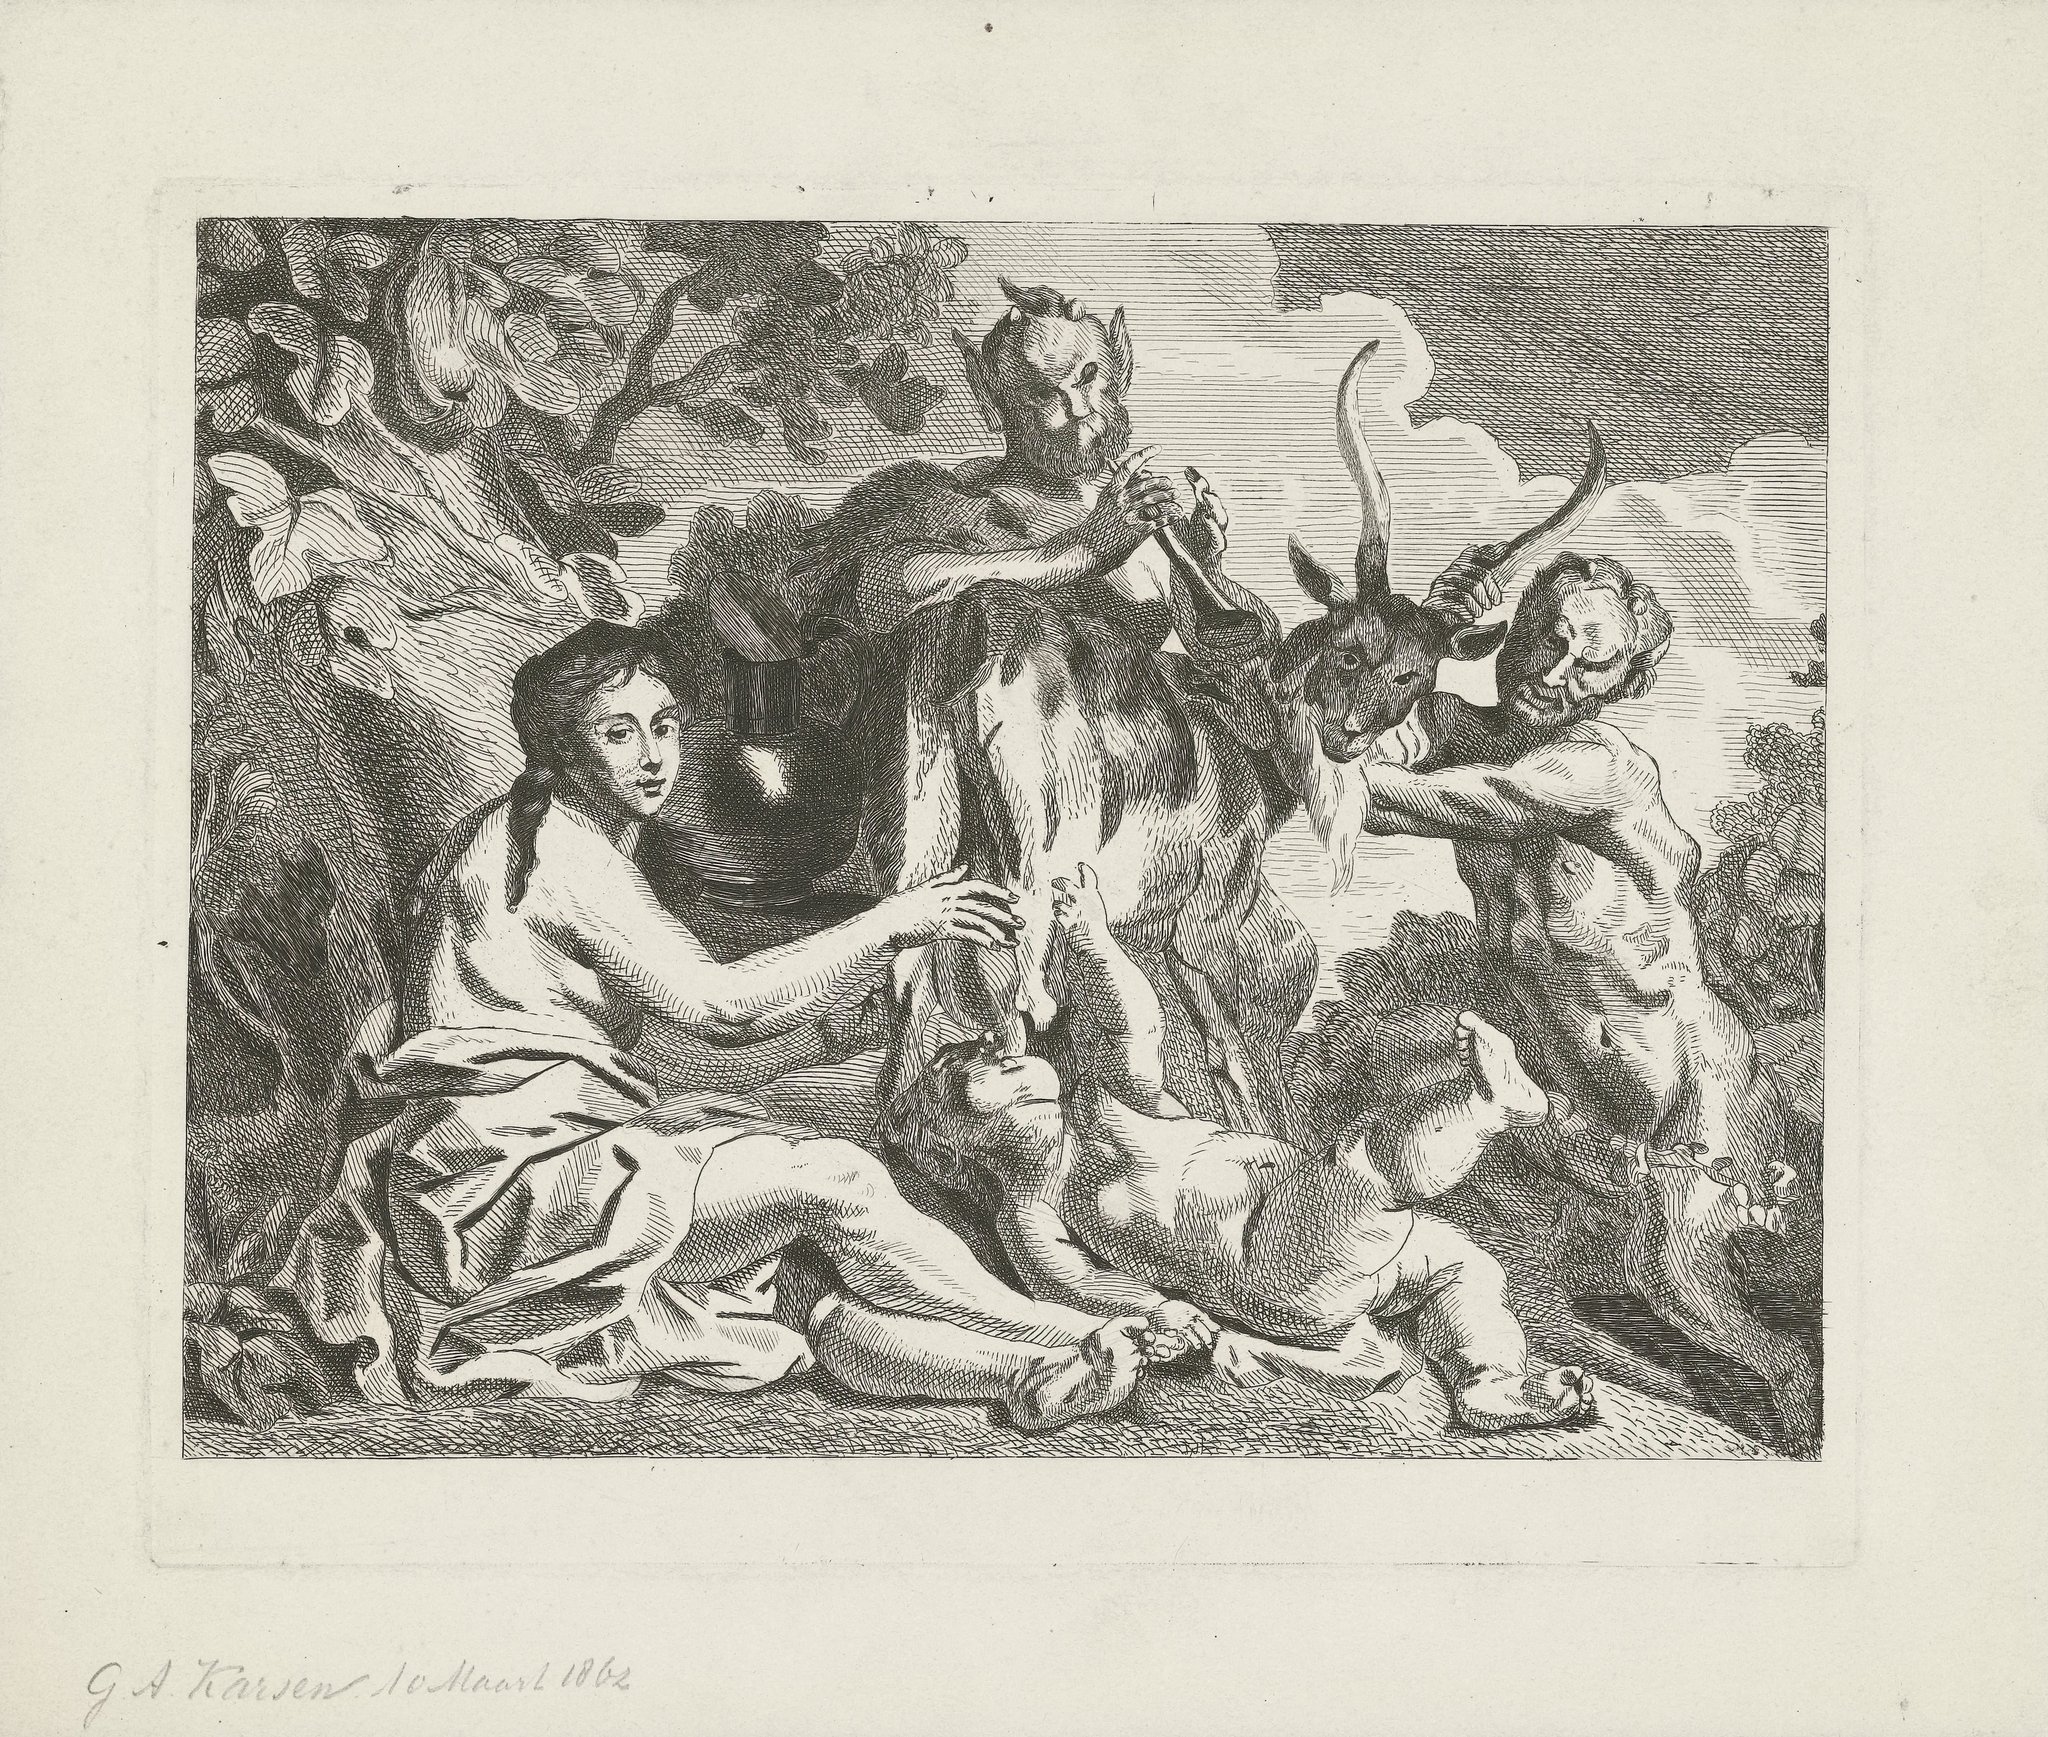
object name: print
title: Het kind Jupiter wordt gevoed door de geit Amalthea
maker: george andries karsen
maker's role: print maker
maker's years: 1843-1912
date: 1862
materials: paper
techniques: engraving, etching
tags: nymphs (in general); 'ninfe in commune' (ripa), satyr(s) (in general), goat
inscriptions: inscription: ‘G.A .Karsen 10 Maart 1862’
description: In een landschap houdt een sater de geit Amalthea vast aan een van haar horens. Het kind Jupiter drinkt melk uit een van de uiers. Een tweede sater bespeelt een fluit.